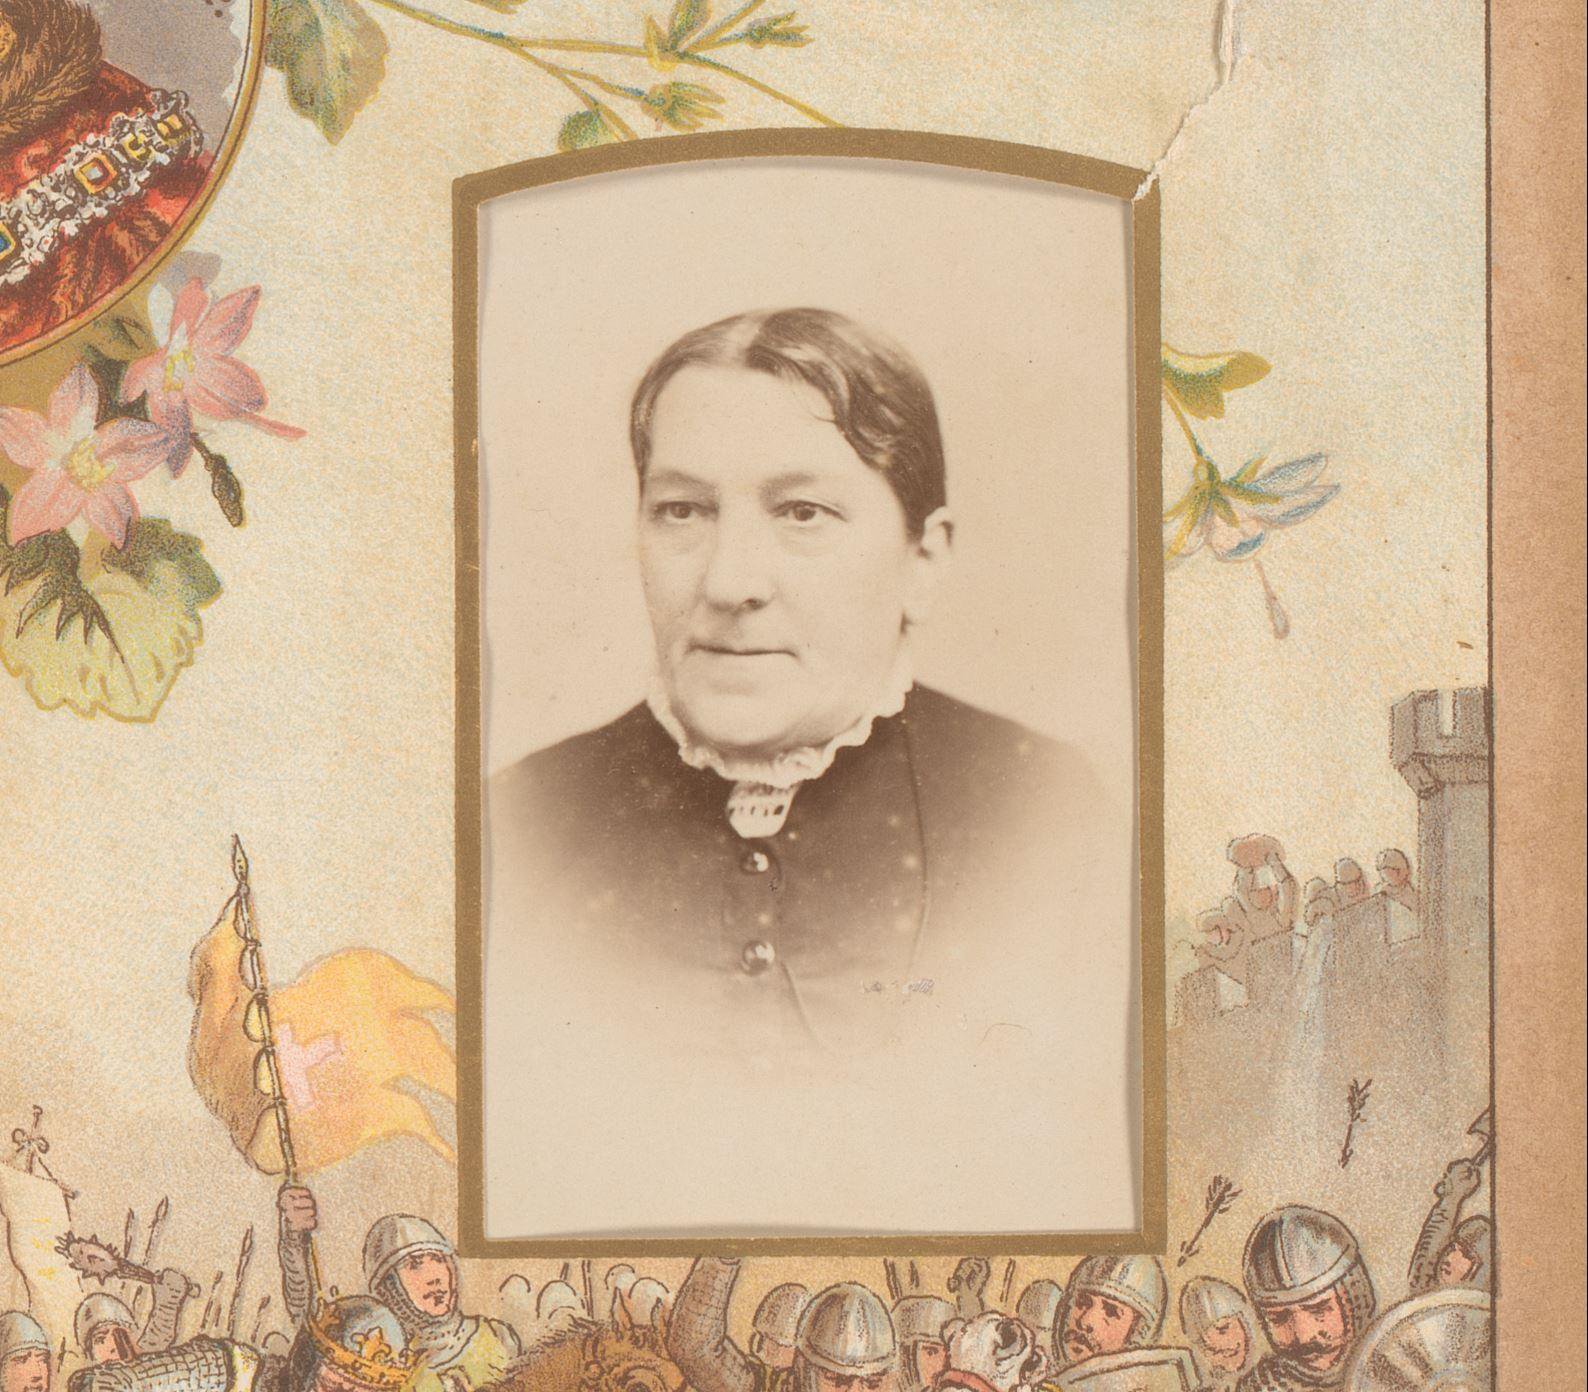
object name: photograph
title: Portret van een vrouw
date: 1882-1900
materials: cardboard, photographic support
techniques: albumen print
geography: newcastle upon tyne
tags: historical persons - bb - woman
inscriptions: inscription: ‘Photographers/ to Her Majesty the Queen/ and Their Royal Highnesses/ The Prince & Princess of Wales/ Miniature & Portrait Painters/ A. & G. Taylor/ 4, St Nicholas Building/ NEWCASTLE on TYNE/ and at/ 106, High St Stockton/ 95, Newgate St Bishop Auckland/ and 15, Norfolk St. Sunderland/ (...)’